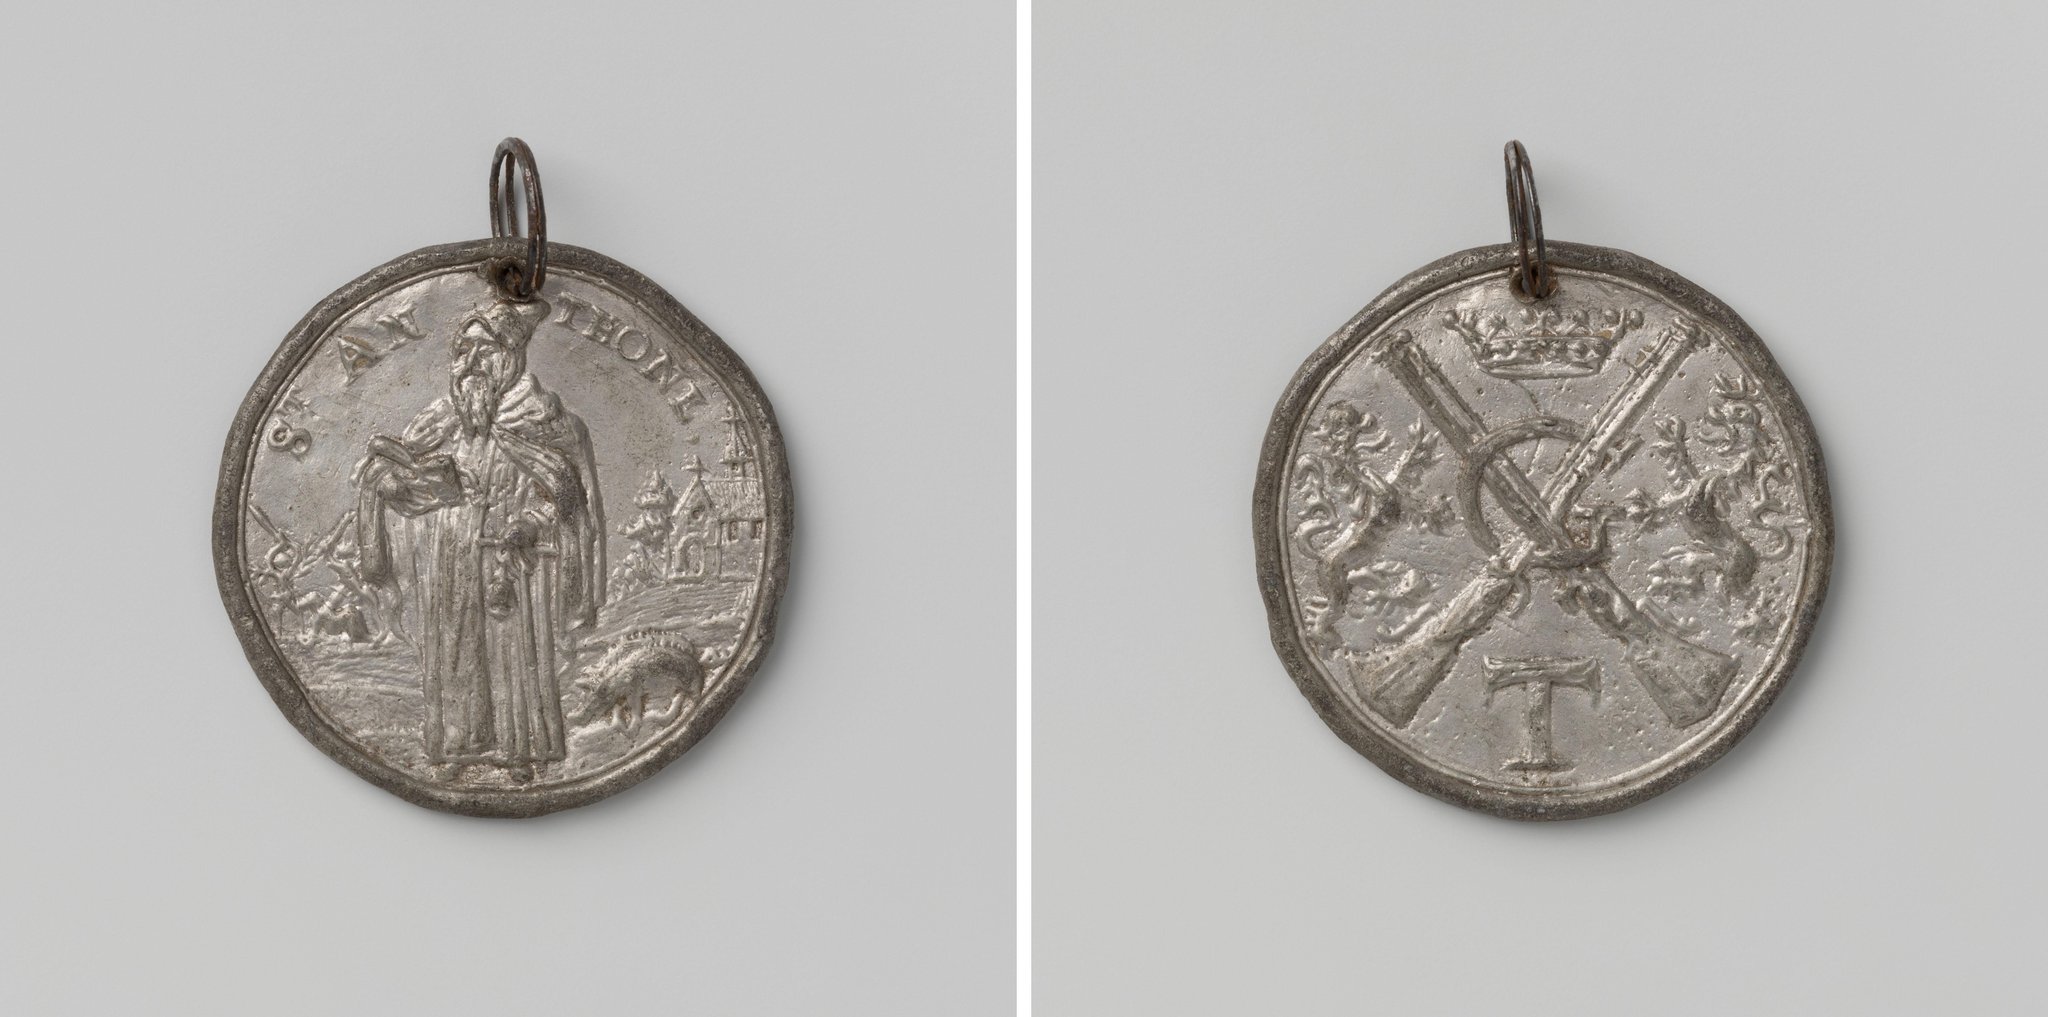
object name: marksman medal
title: Schutterij van St. Antonius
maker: Anonymous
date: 1550-1700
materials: tin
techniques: casting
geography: amsterdam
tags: amsterdam